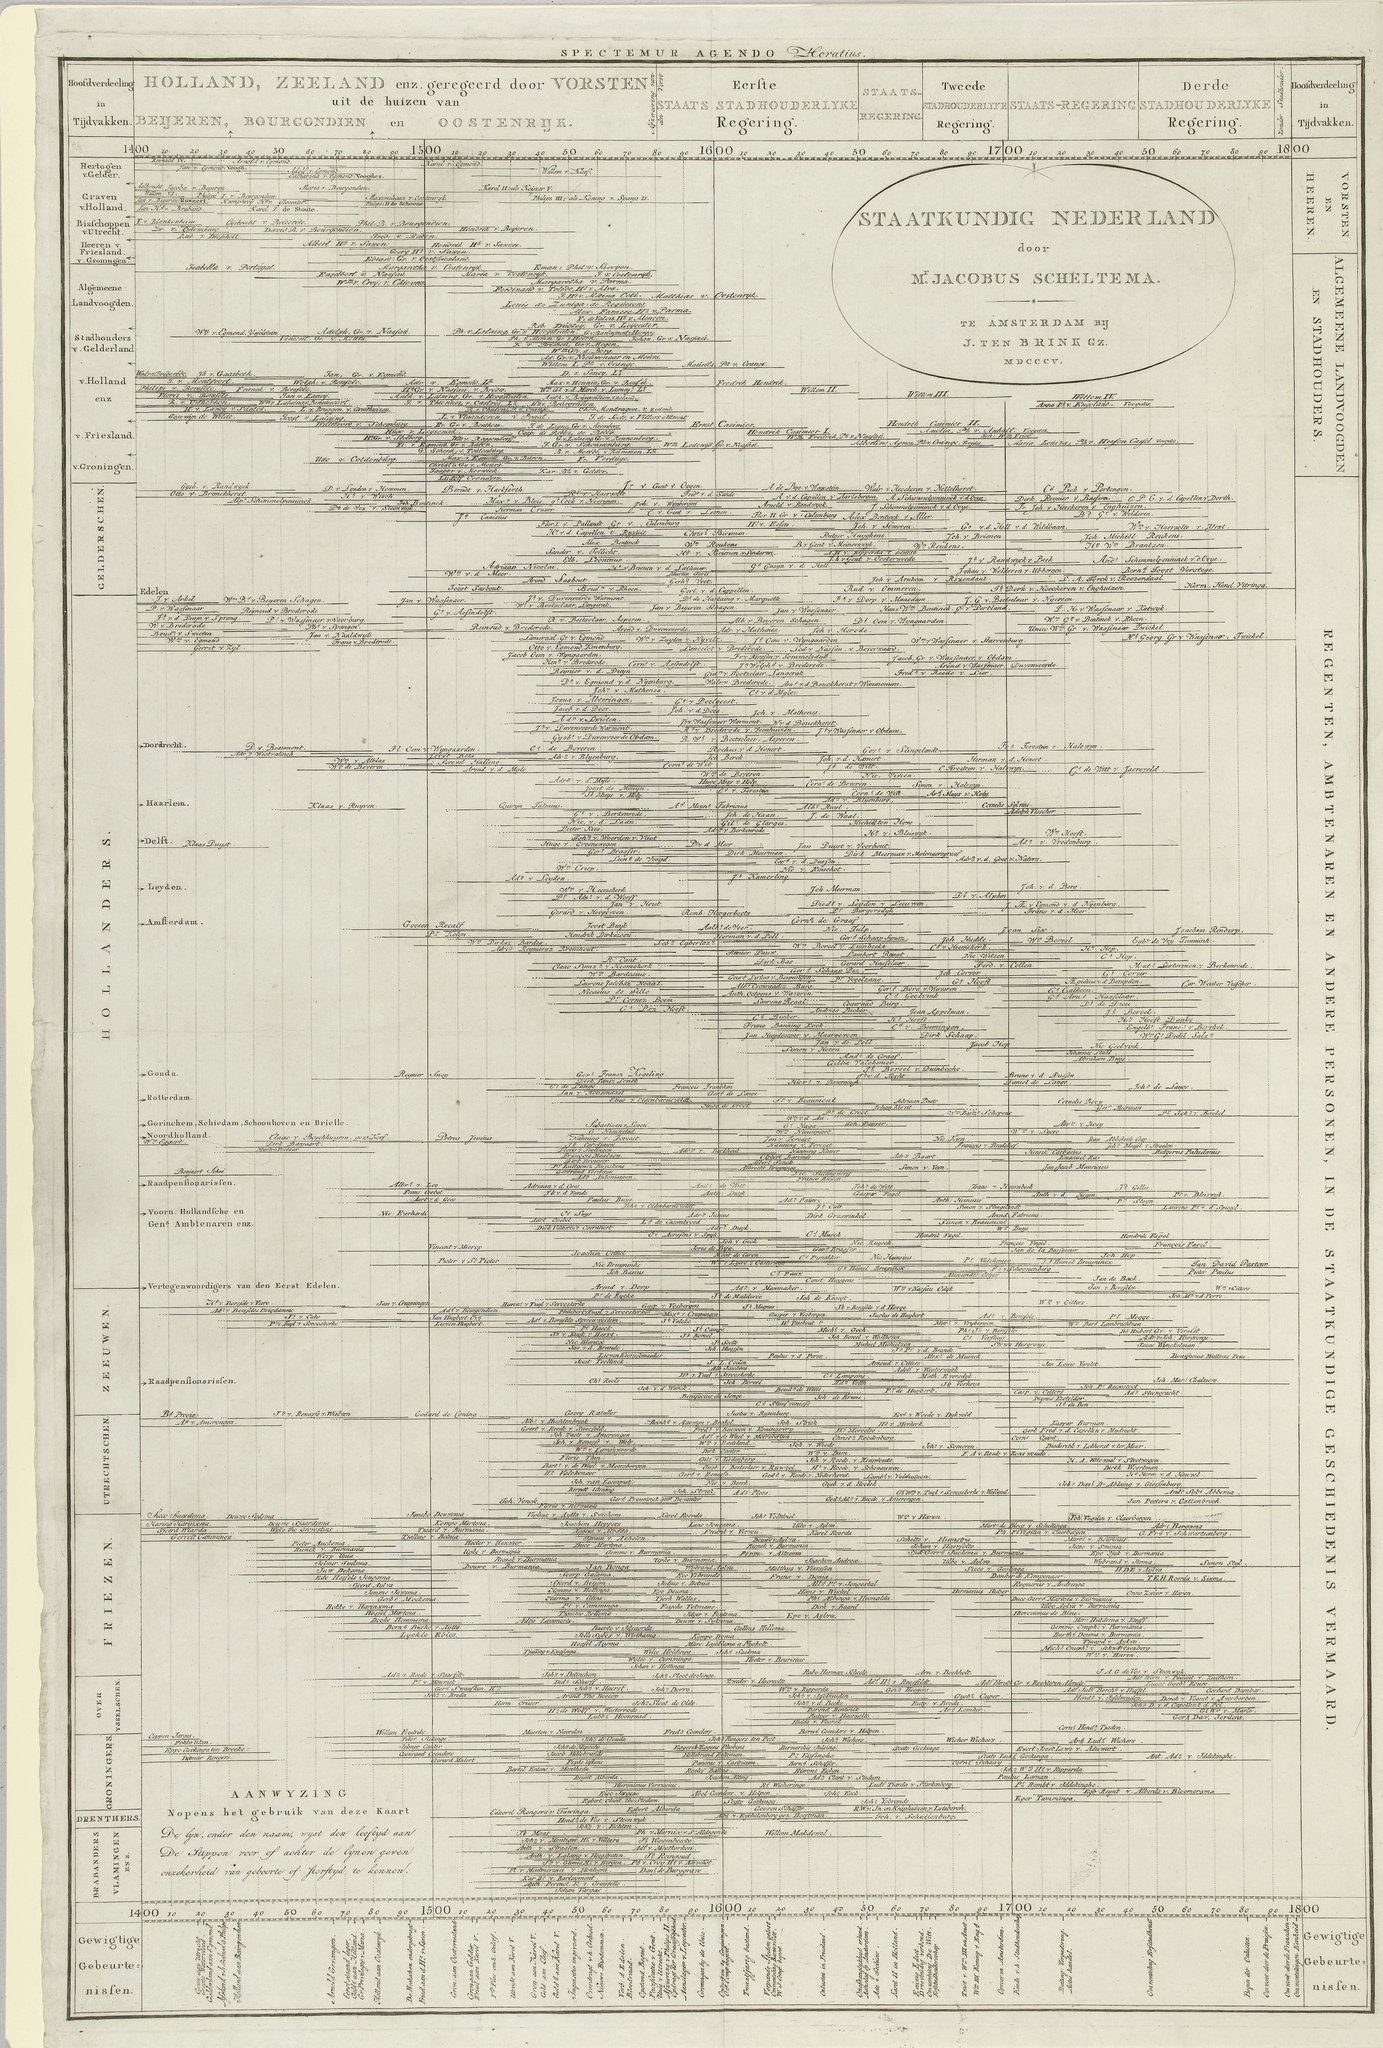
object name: print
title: Biografische kaart van belangrijke Nederlanders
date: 1805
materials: paper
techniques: etching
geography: amsterdam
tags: statistic diagram, graph; pictorial chart, etc., netherlands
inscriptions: date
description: Grote biografische kaart of tabel waarin de namen van voor de Staatkundige geschiedenis van Nederland belangrijke personen afgezet worden tegen een tijdsbalk met jaartallen en gebeurtenissen en met een indeling naar geografische regio.